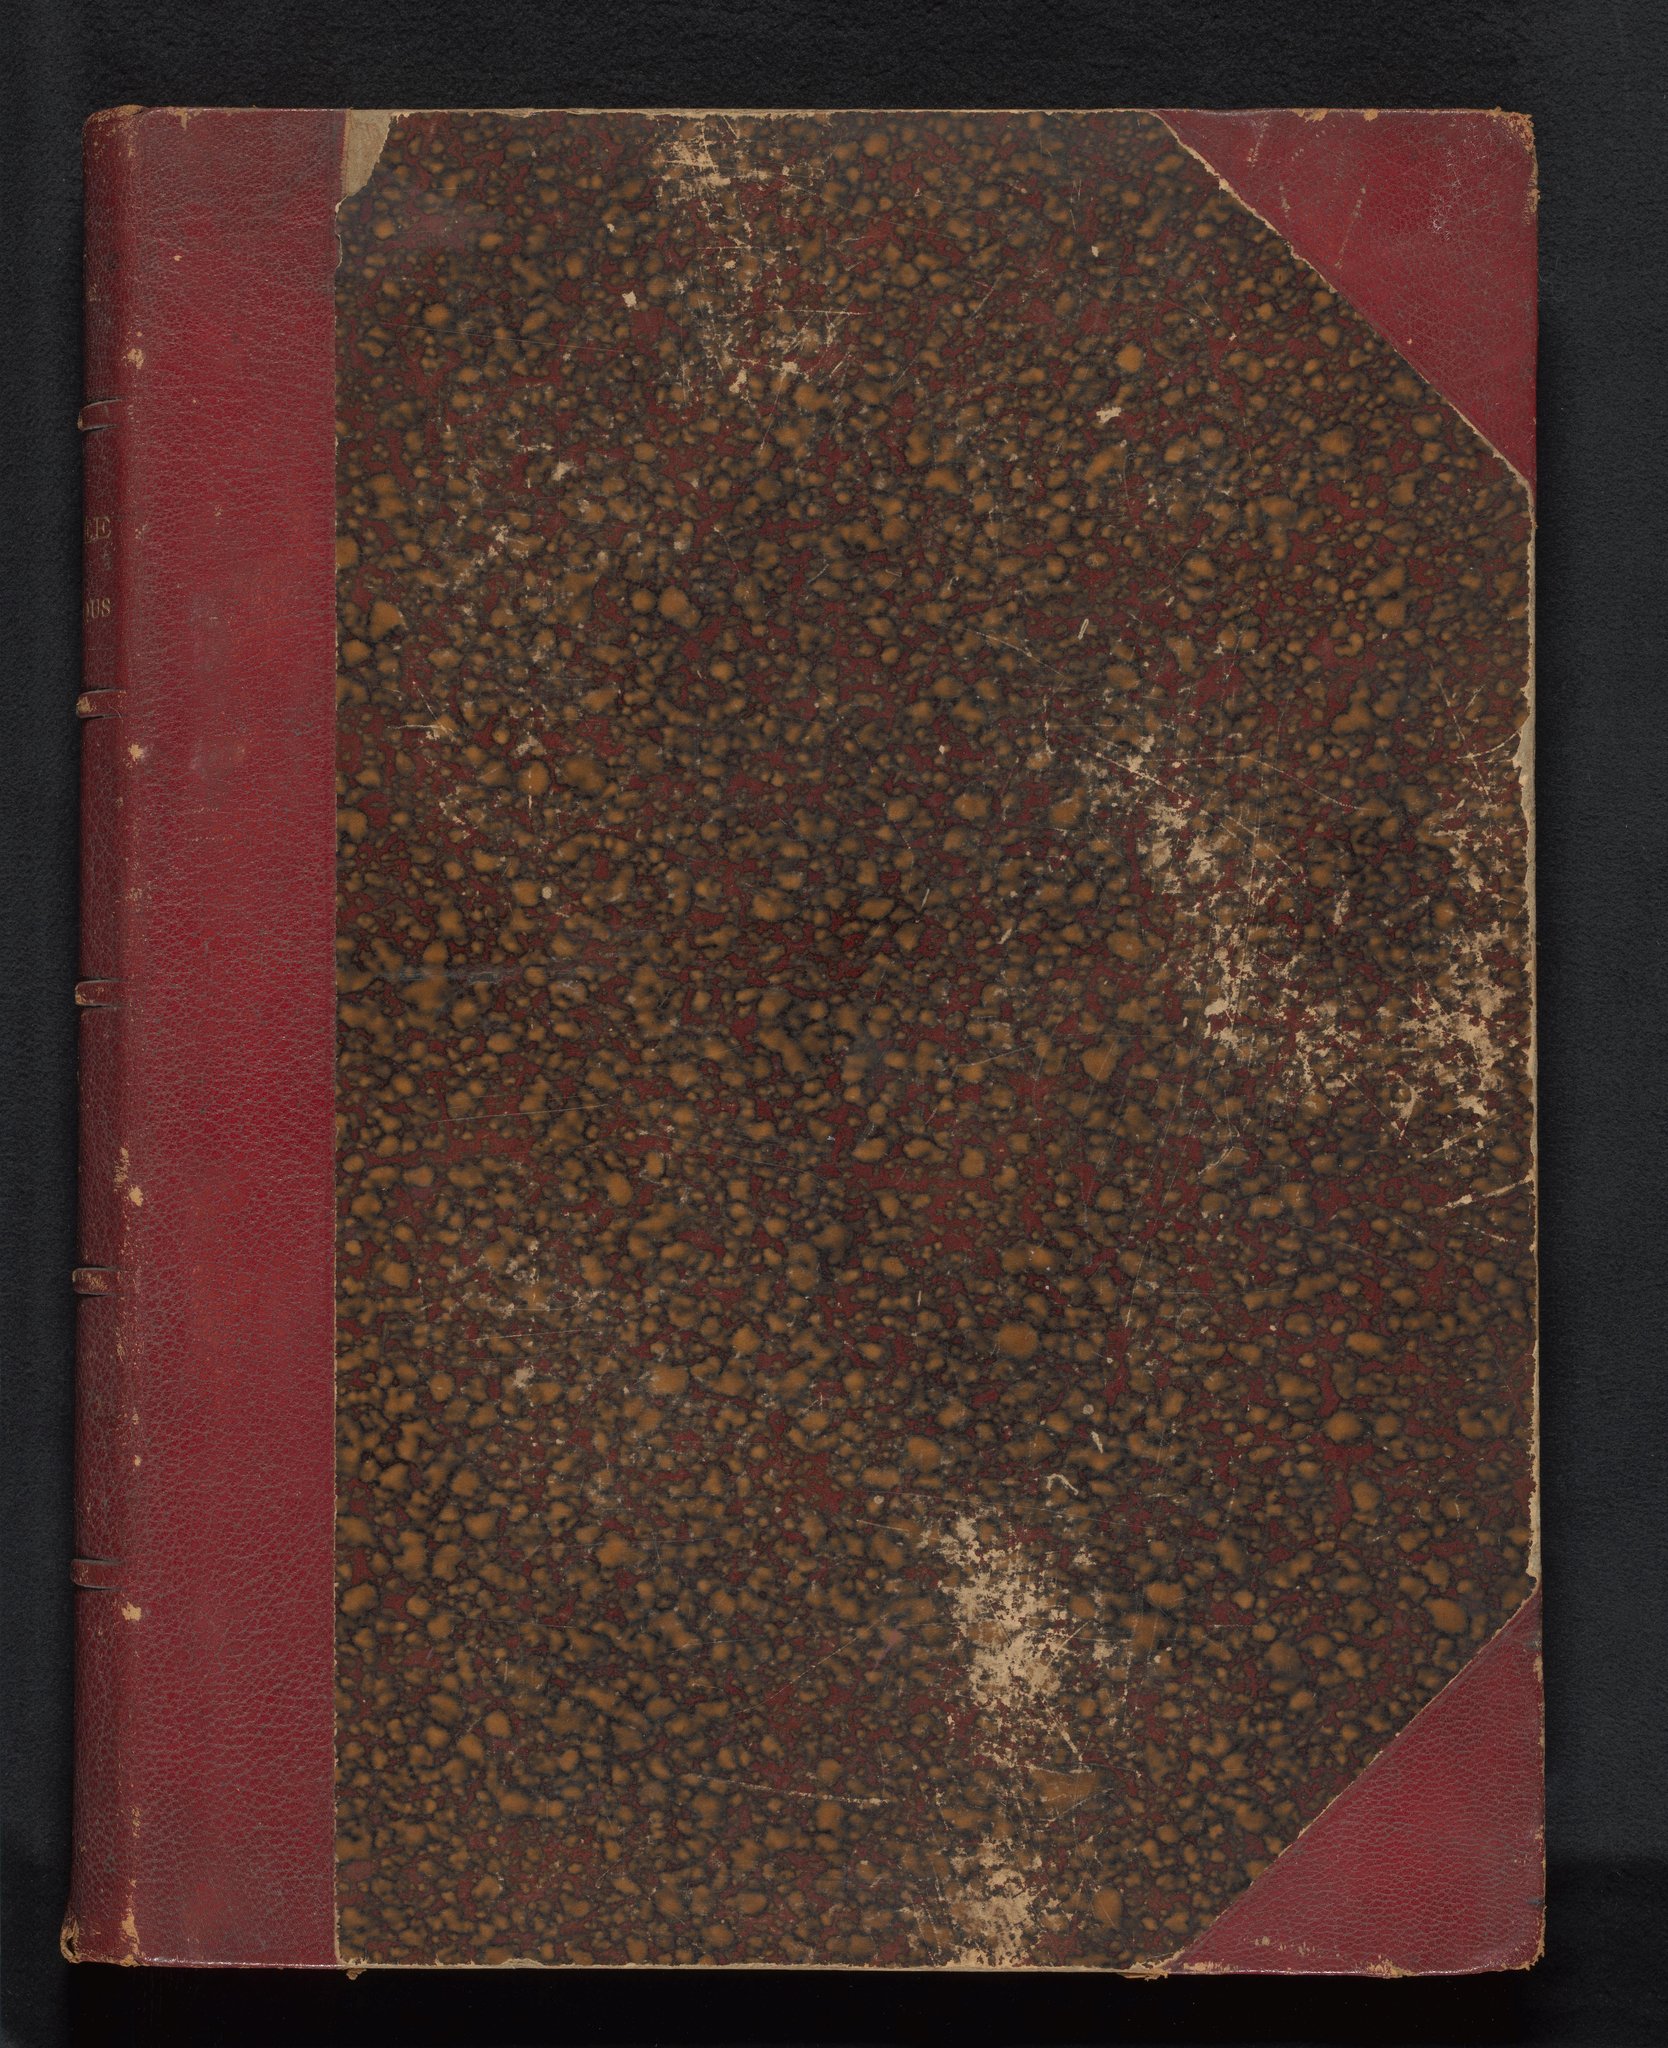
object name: book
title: Musée pour tous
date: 1877-1879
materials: linen, paper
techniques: printing, marbled paper, woodburytype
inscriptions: date: ‘AUG 1994’